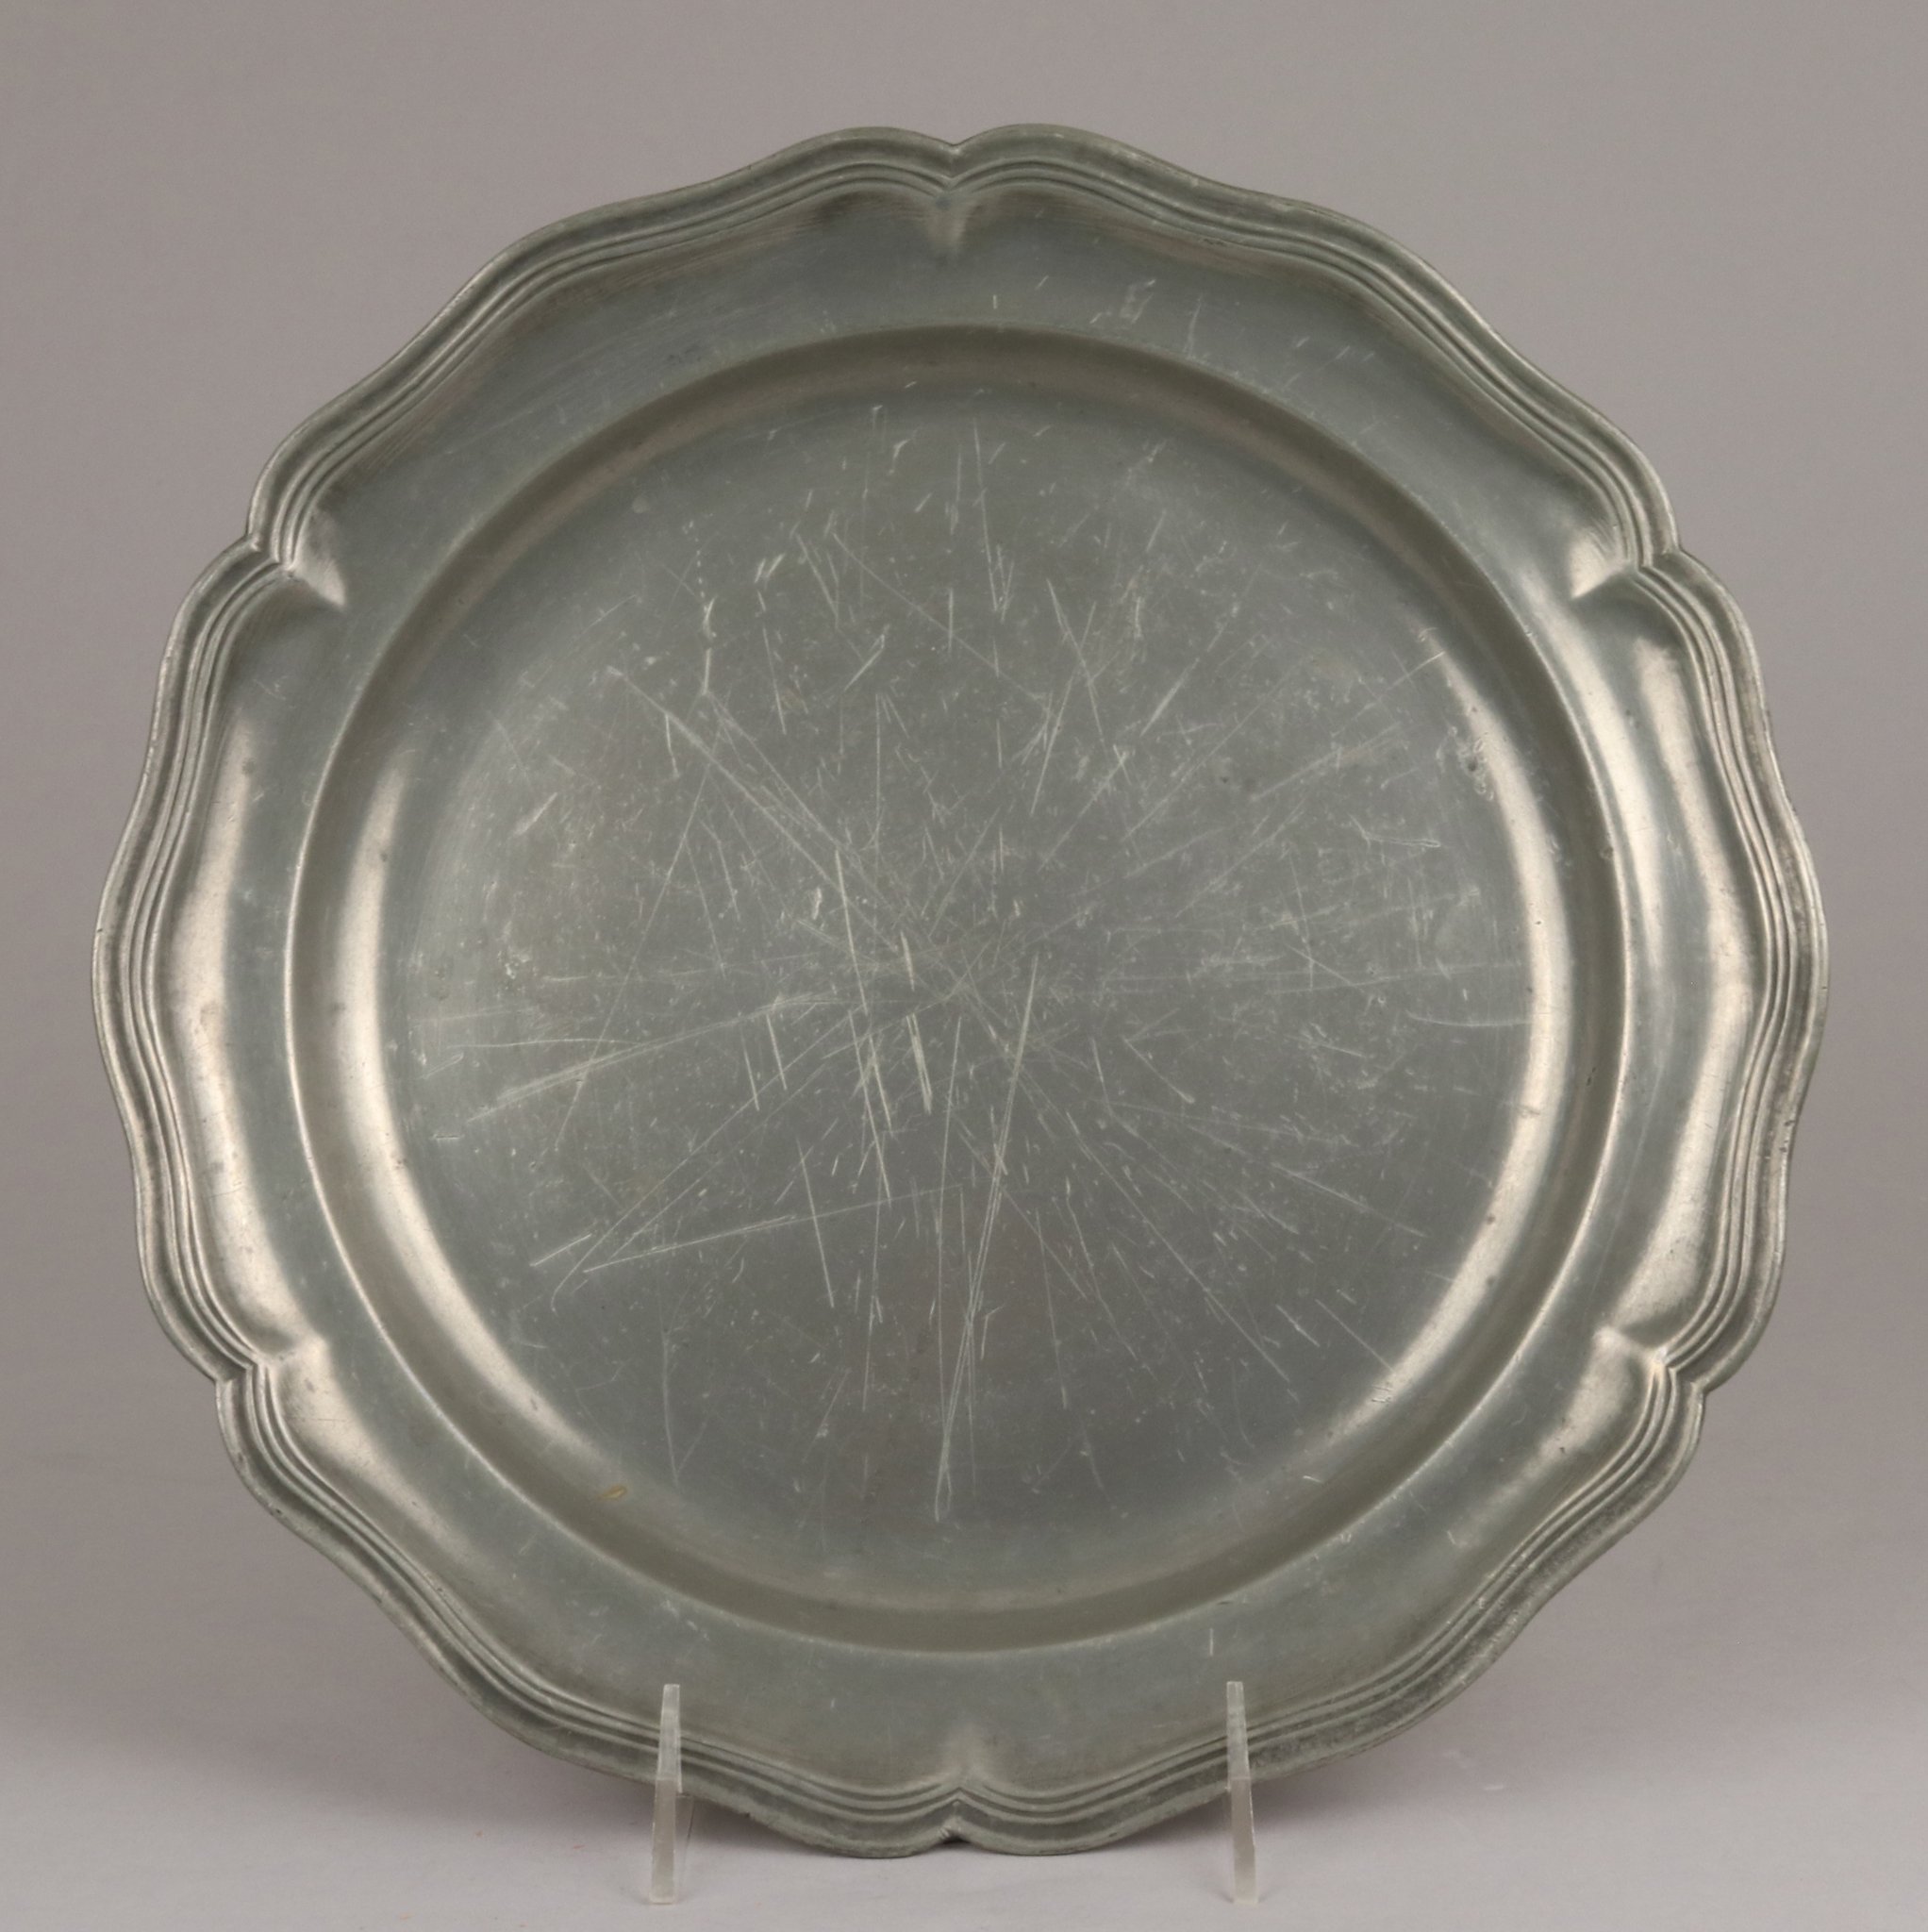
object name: dish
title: Pair of dishes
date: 1701-1800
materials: pewter